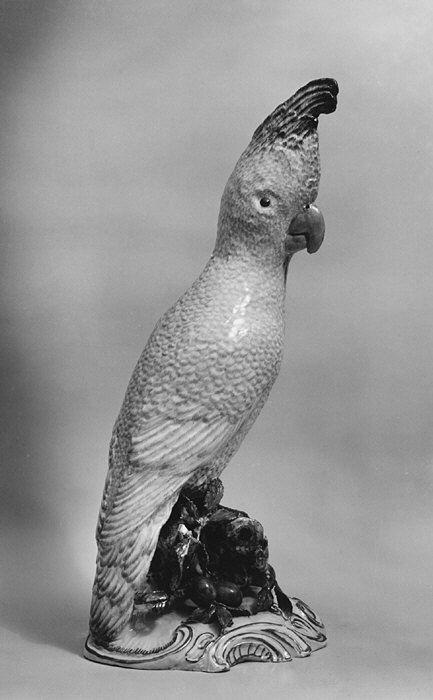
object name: figure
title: Cockatoo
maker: ludwigsburg porcelain manufactory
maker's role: manufactory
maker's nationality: german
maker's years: 1758-1824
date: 1765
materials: hard paste porcelain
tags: birds